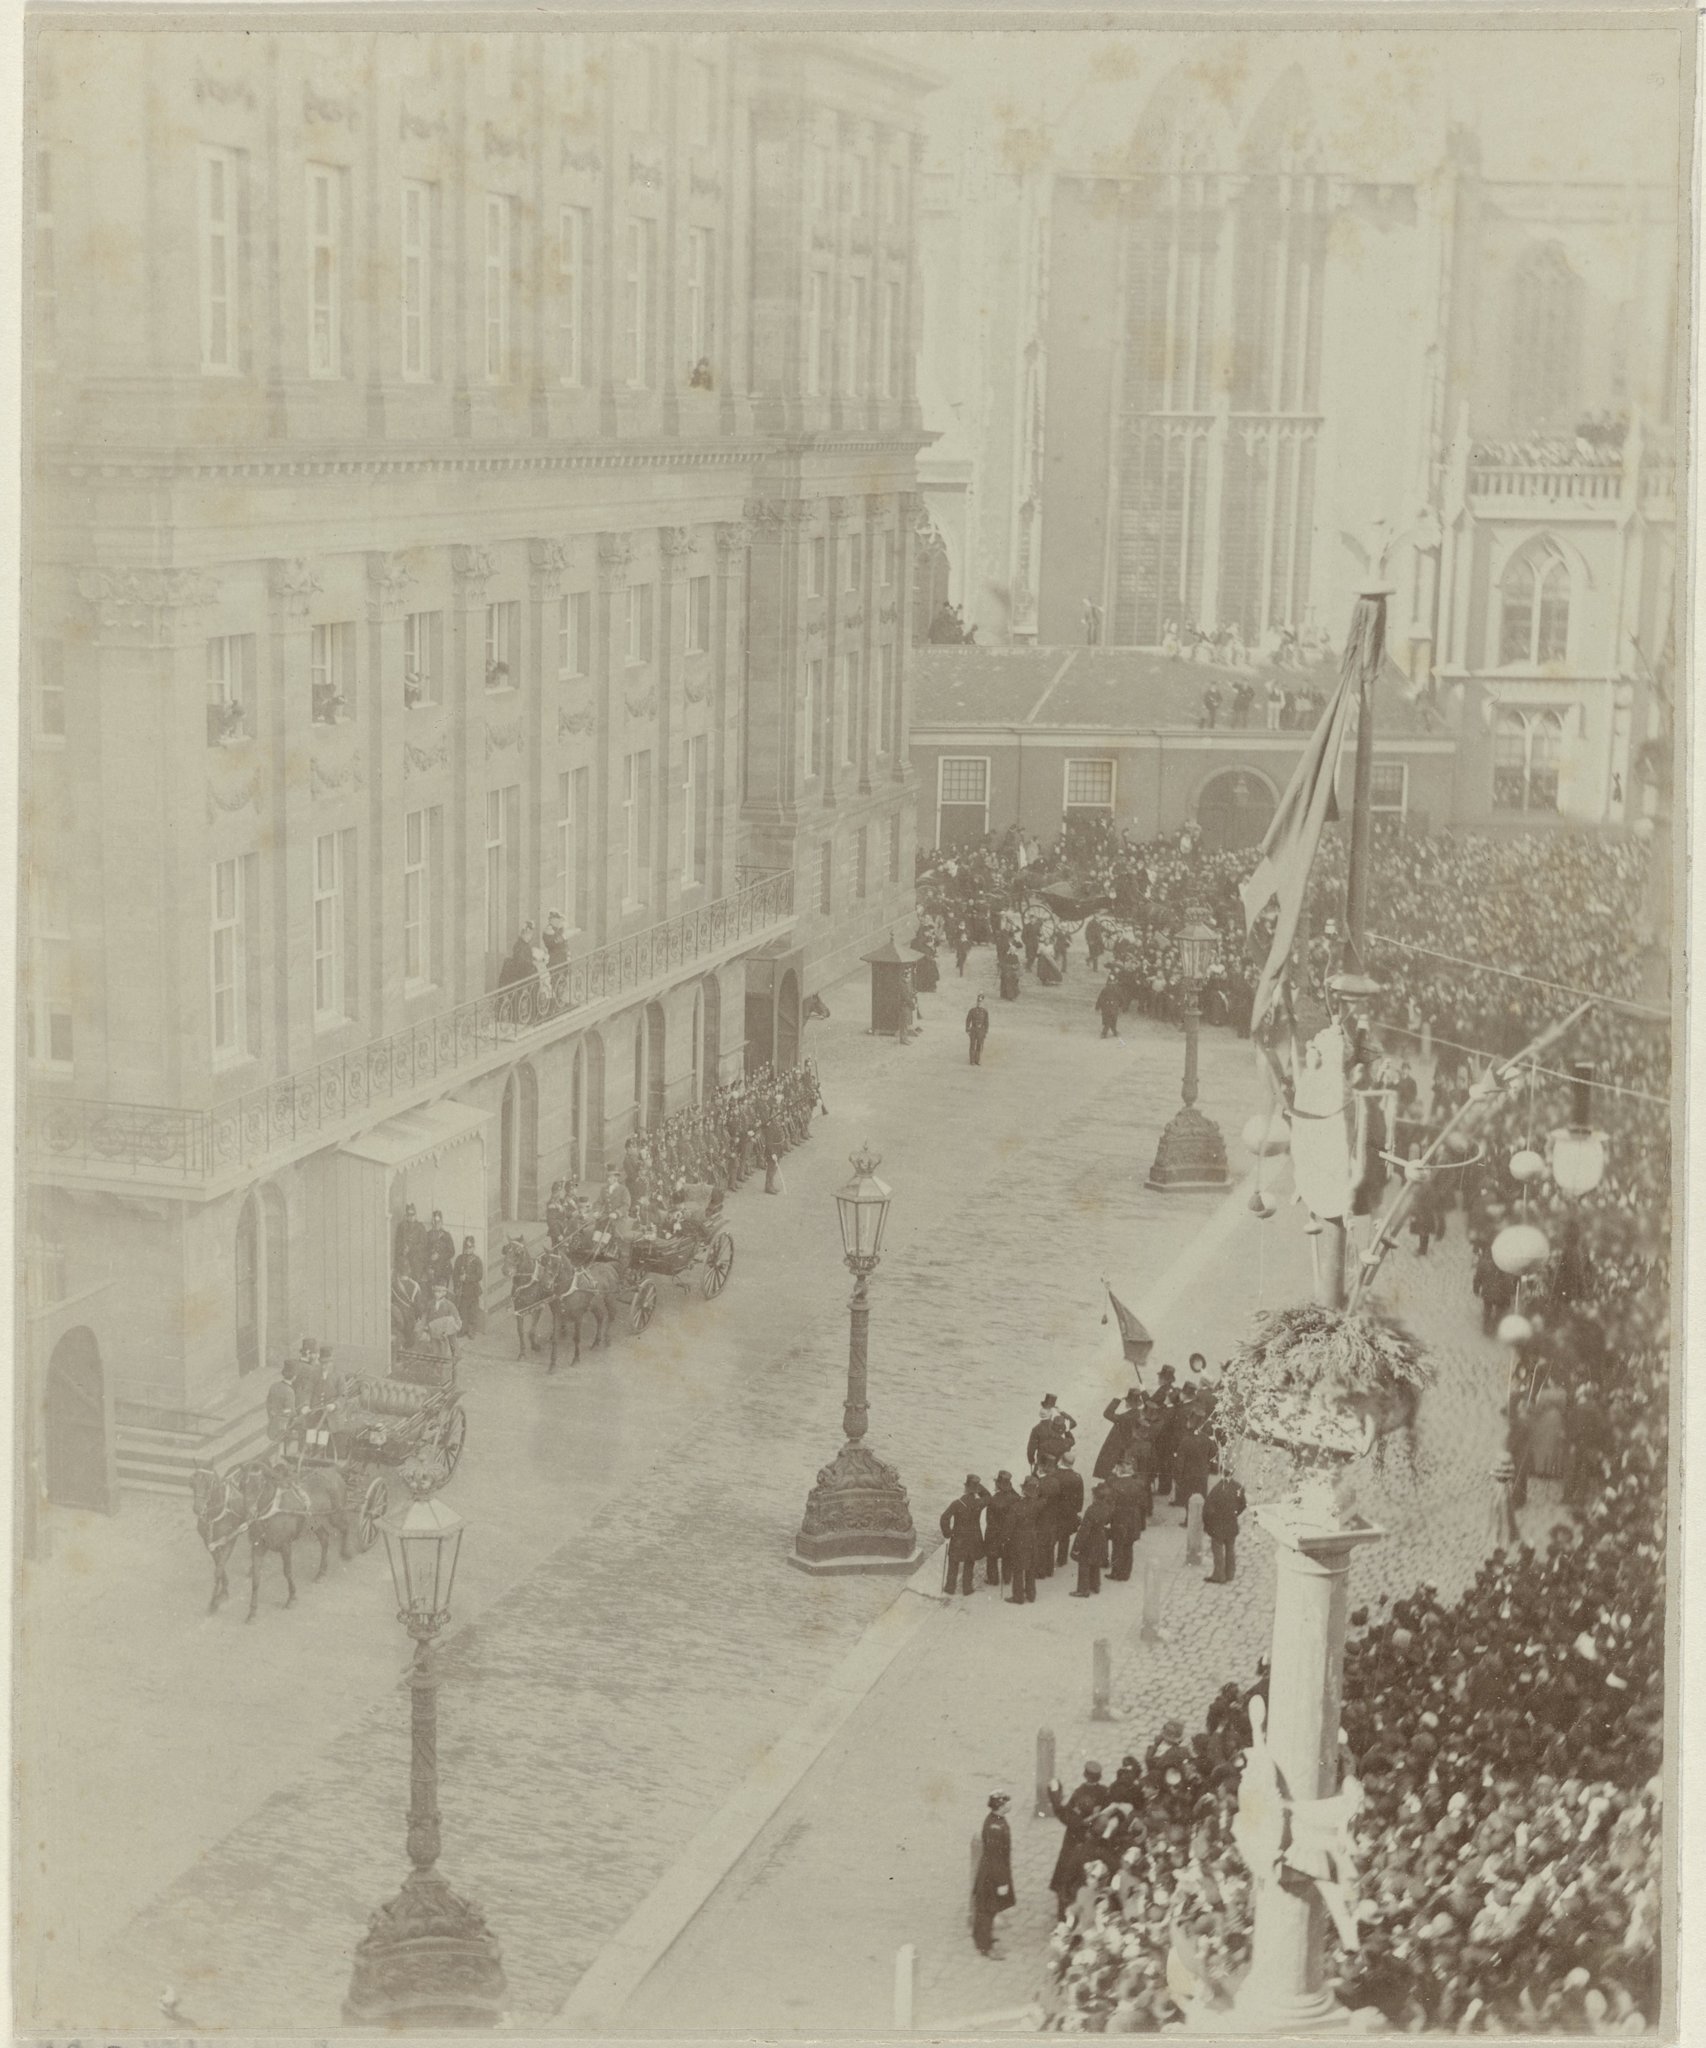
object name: photograph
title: Willem III, koning der Nederlanden, Emma, koningin-regentes der Nederlanden, en Wilhelmina, koningin der Nederlanden, op het balkon van het Koninklijk Paleis op de Dam bij hun bezoek aan Amsterdam op 12 april 1887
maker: henri de louw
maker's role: fotograaf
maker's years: 1851-1944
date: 1887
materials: paper, photographic support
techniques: albumen print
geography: delft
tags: the hague, print maker, wilhelmina of the netherlands, emma (queen consort of the netherlands), brussels, willem iii (koning der nederlanden), royal palace of amsterdam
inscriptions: collector's mark: Lugt 2228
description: De hier vermelde titel verwijst naar de hoogst verkregen titel van de geportretteerde, niet per se naar de titel die de geportretteerde op deze voorstelling draagt.